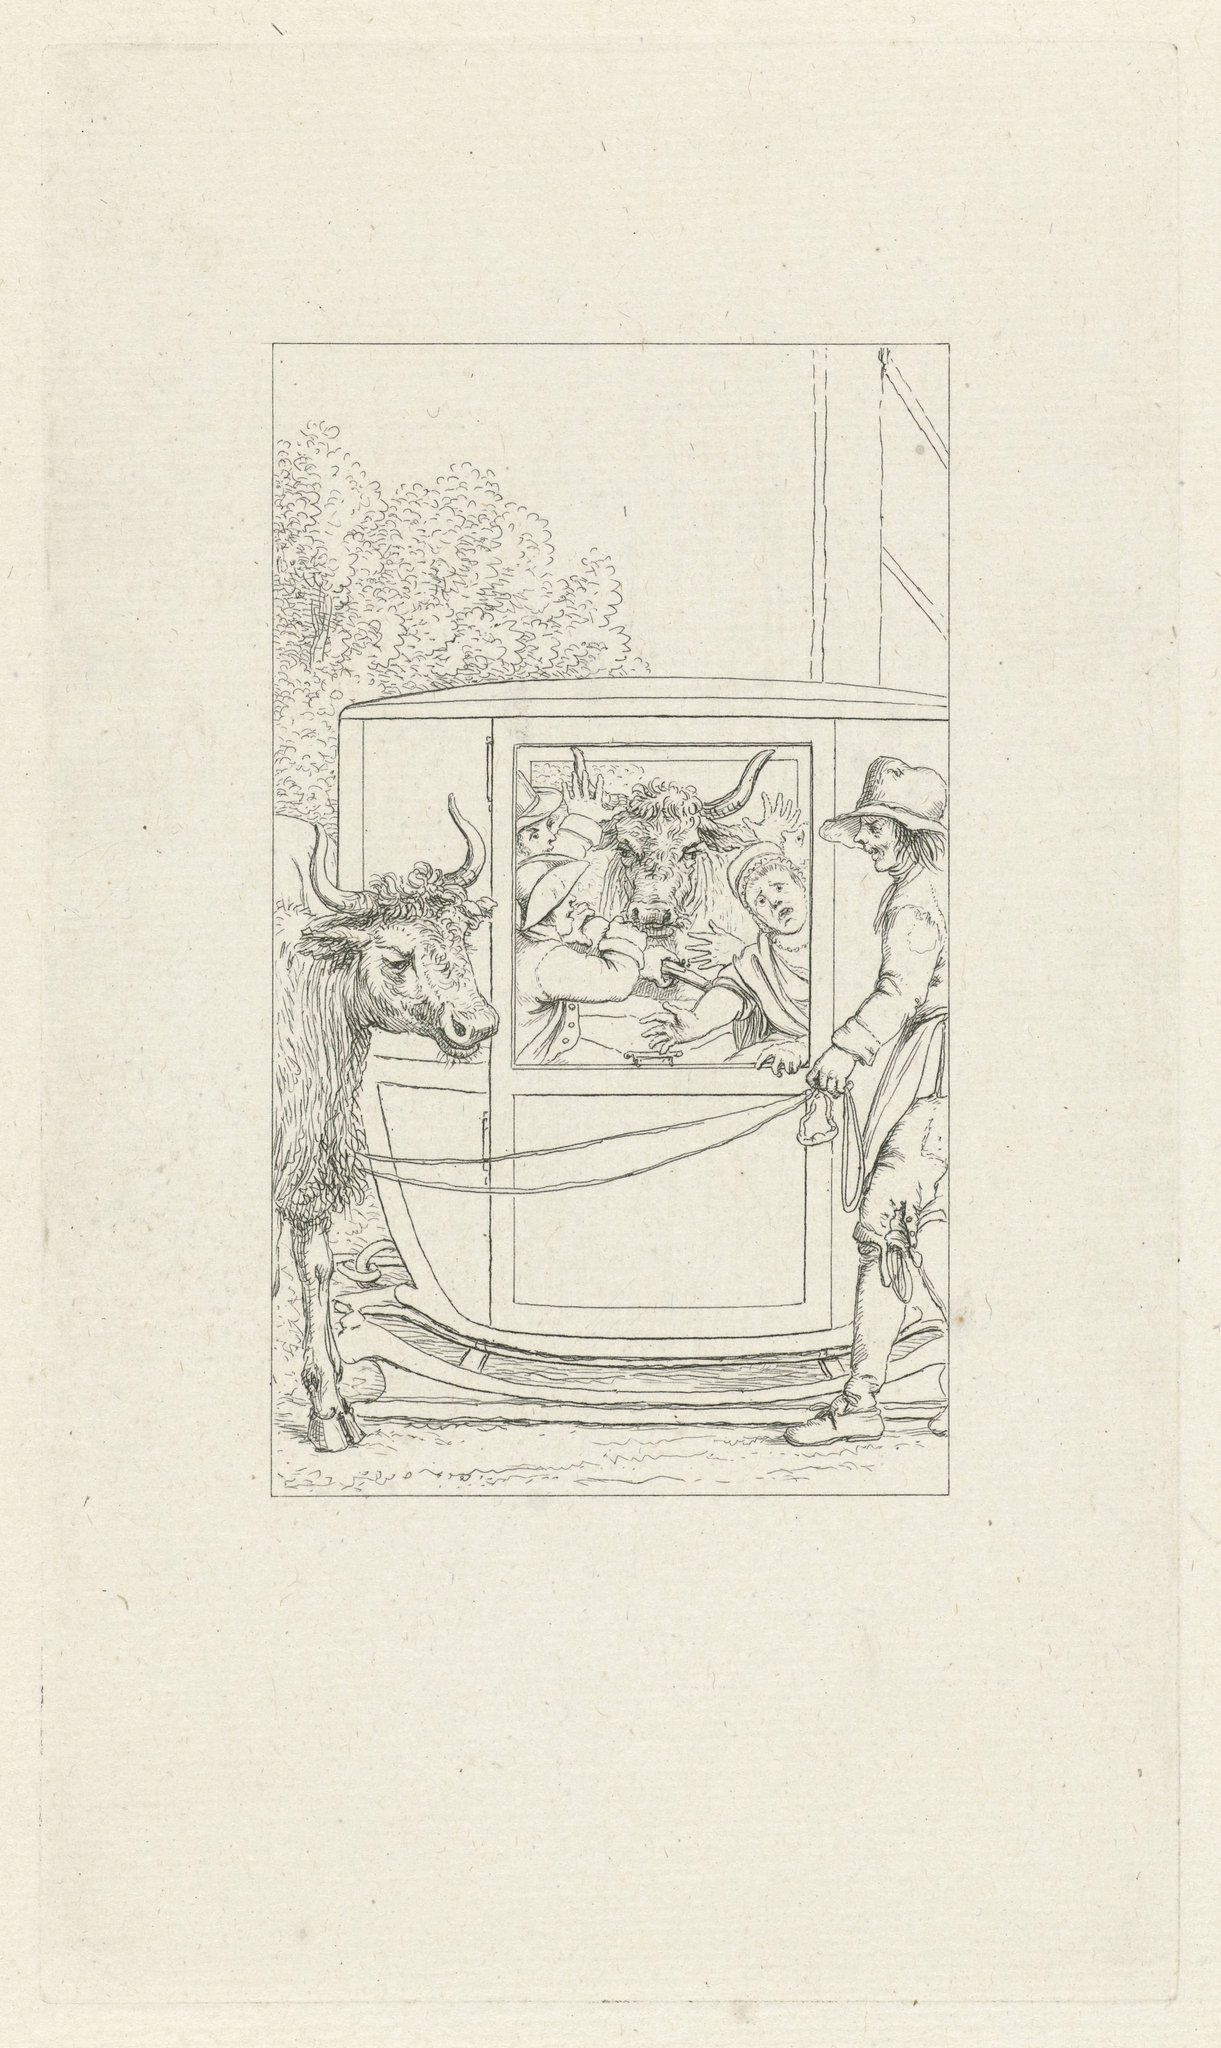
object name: print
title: Stieren bij een toeslede met verschrikte figuren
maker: jacob ernst marcus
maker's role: draughtsman, print maker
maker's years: 1774-1826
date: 1784-1826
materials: paper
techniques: etching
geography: amsterdam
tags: bull, animal-drawn sledge (dutch: 'toeslede')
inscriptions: collector's mark: Lugt 2228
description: In een toeslede zitten zeer verschrikt kijkende figuren omdat er aan weerszijden van hun rijtuig twee stieren staan. Een van de dieren is aangelijnd en wordt vastgehouden door een man.